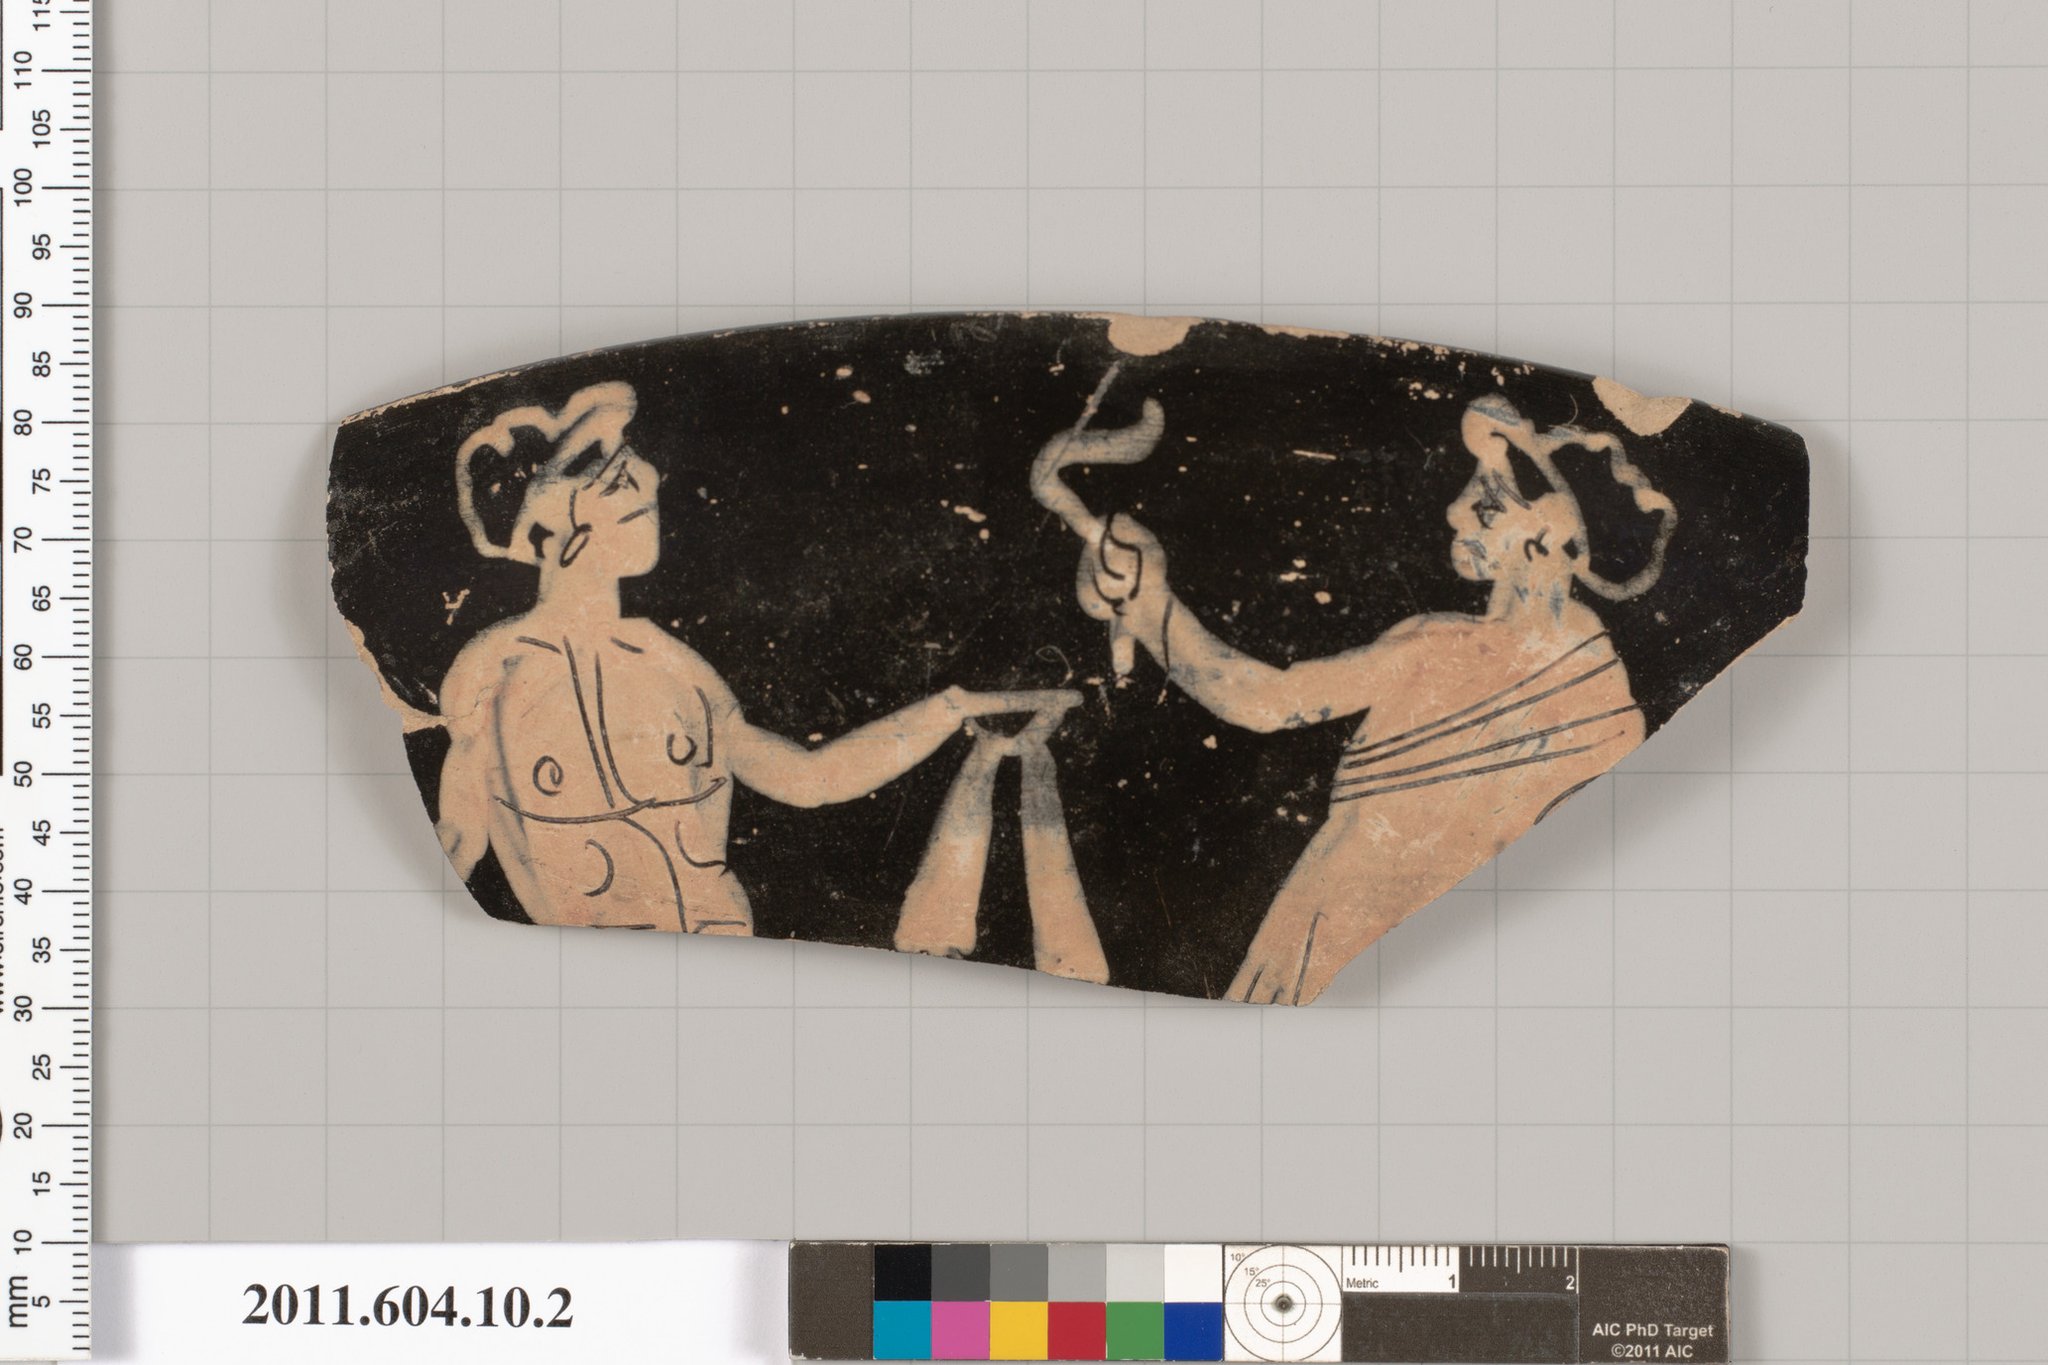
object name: kylix fragment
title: Terracotta rim fragment of a kylix (drinking cup)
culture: etruscan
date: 434-368 BCE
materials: terracotta